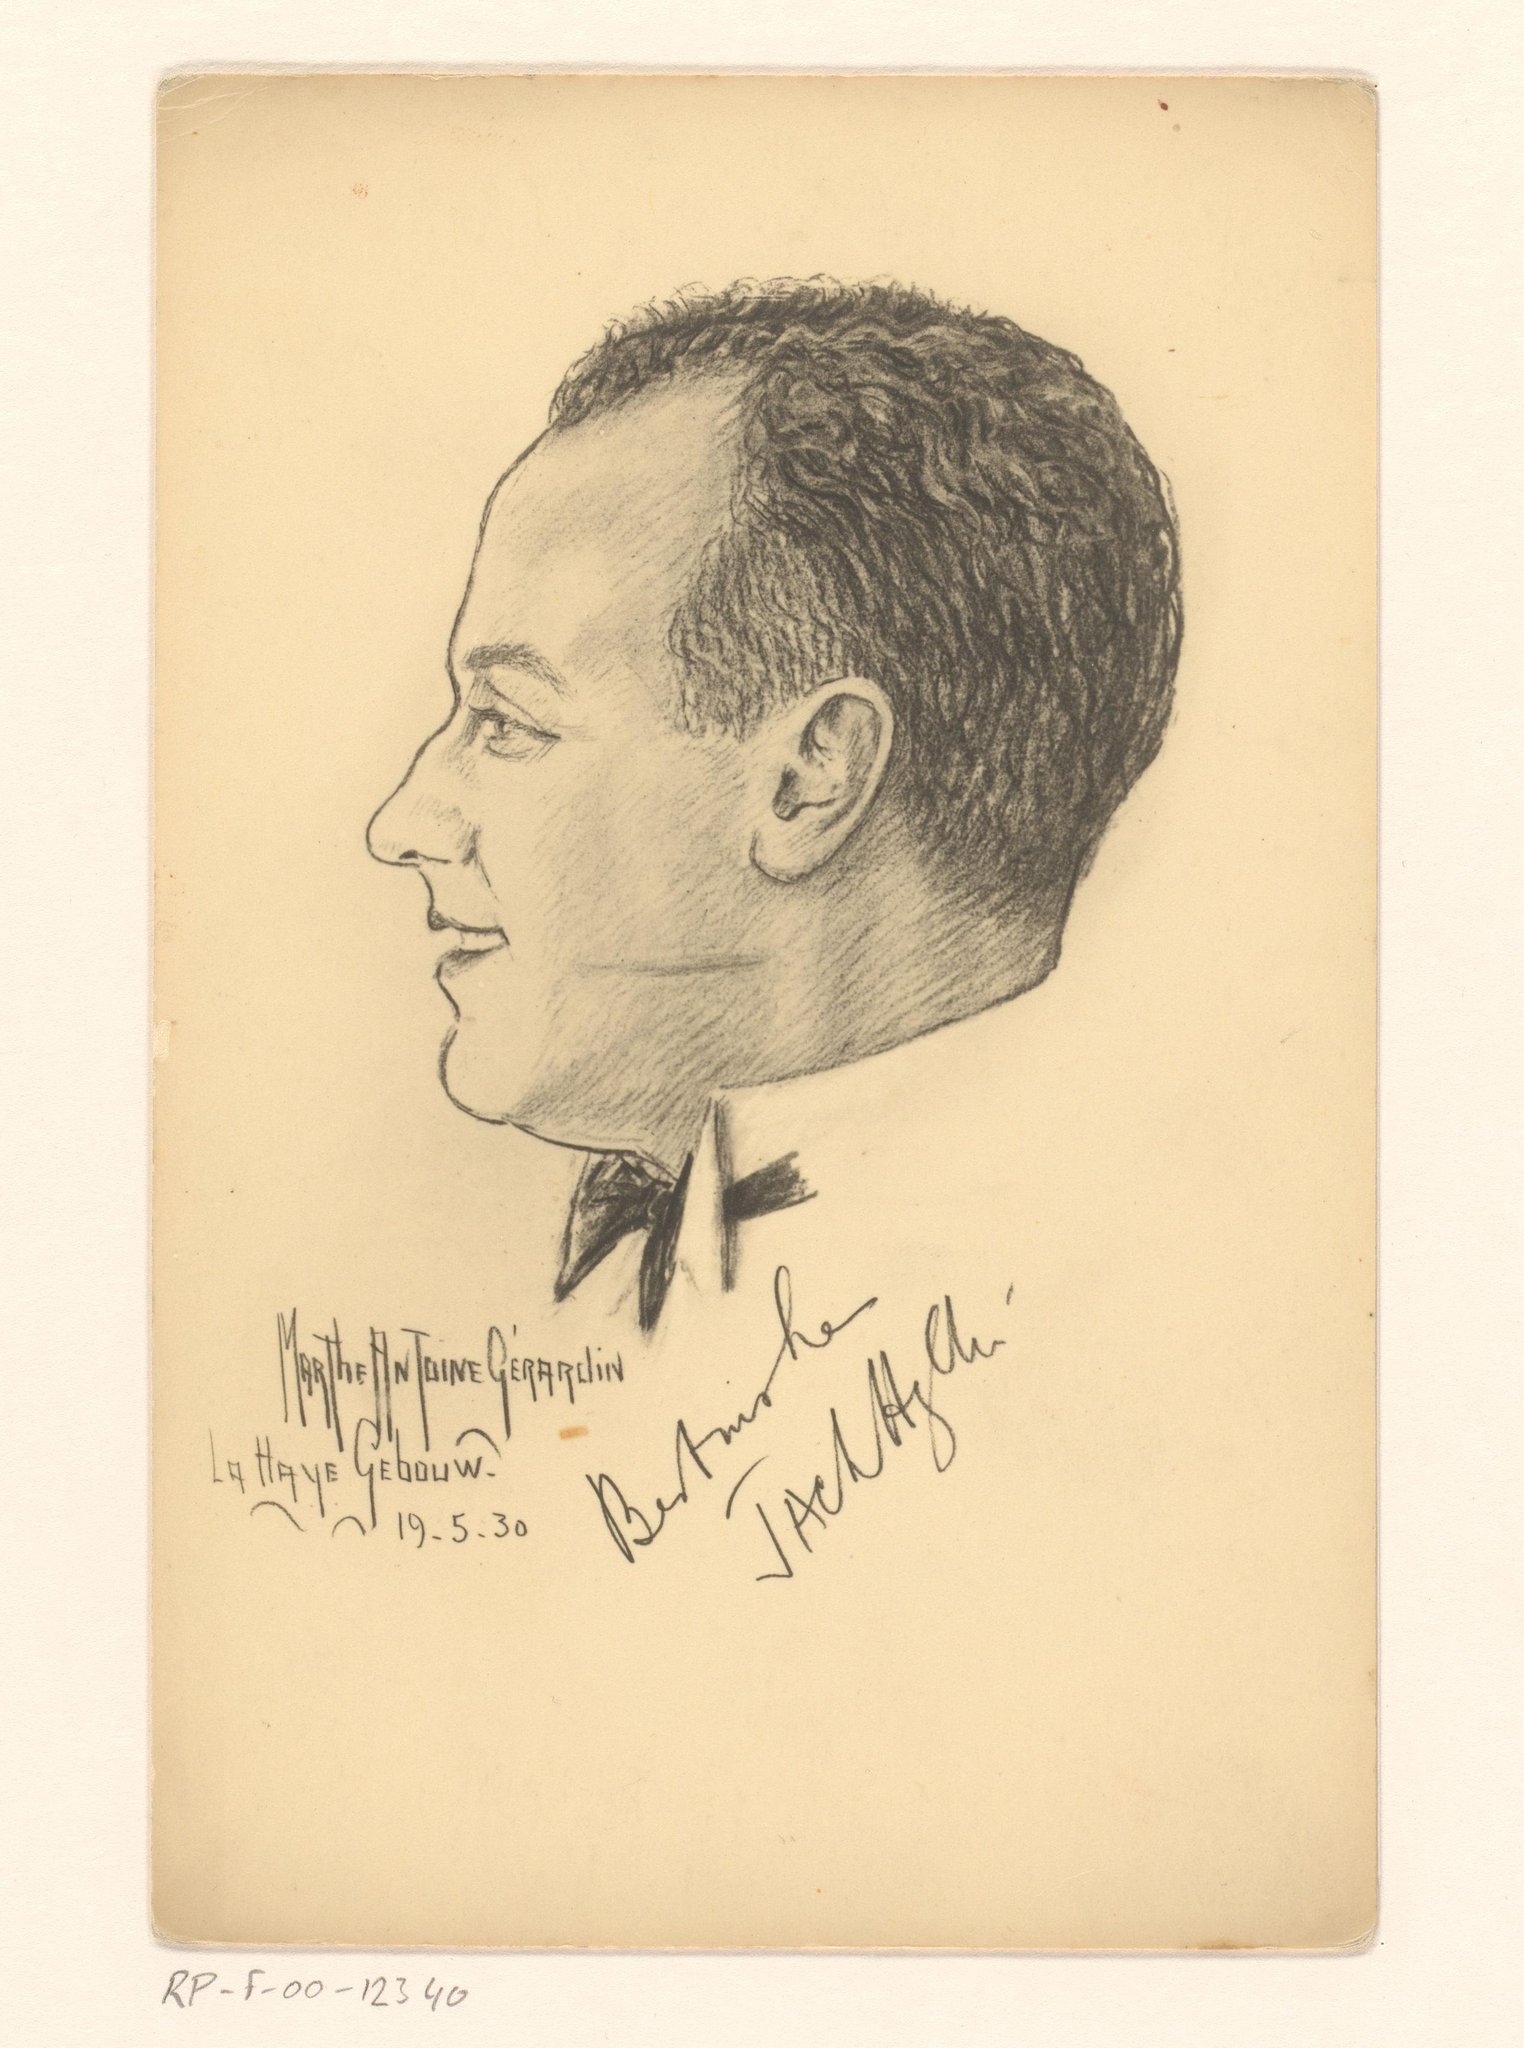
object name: reproduction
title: Fotoreproductie van een getekend portret van Jack Hylton, door Marthe Antoine Gérardin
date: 1930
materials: paper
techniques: gelatin silver print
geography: the hague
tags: historical persons